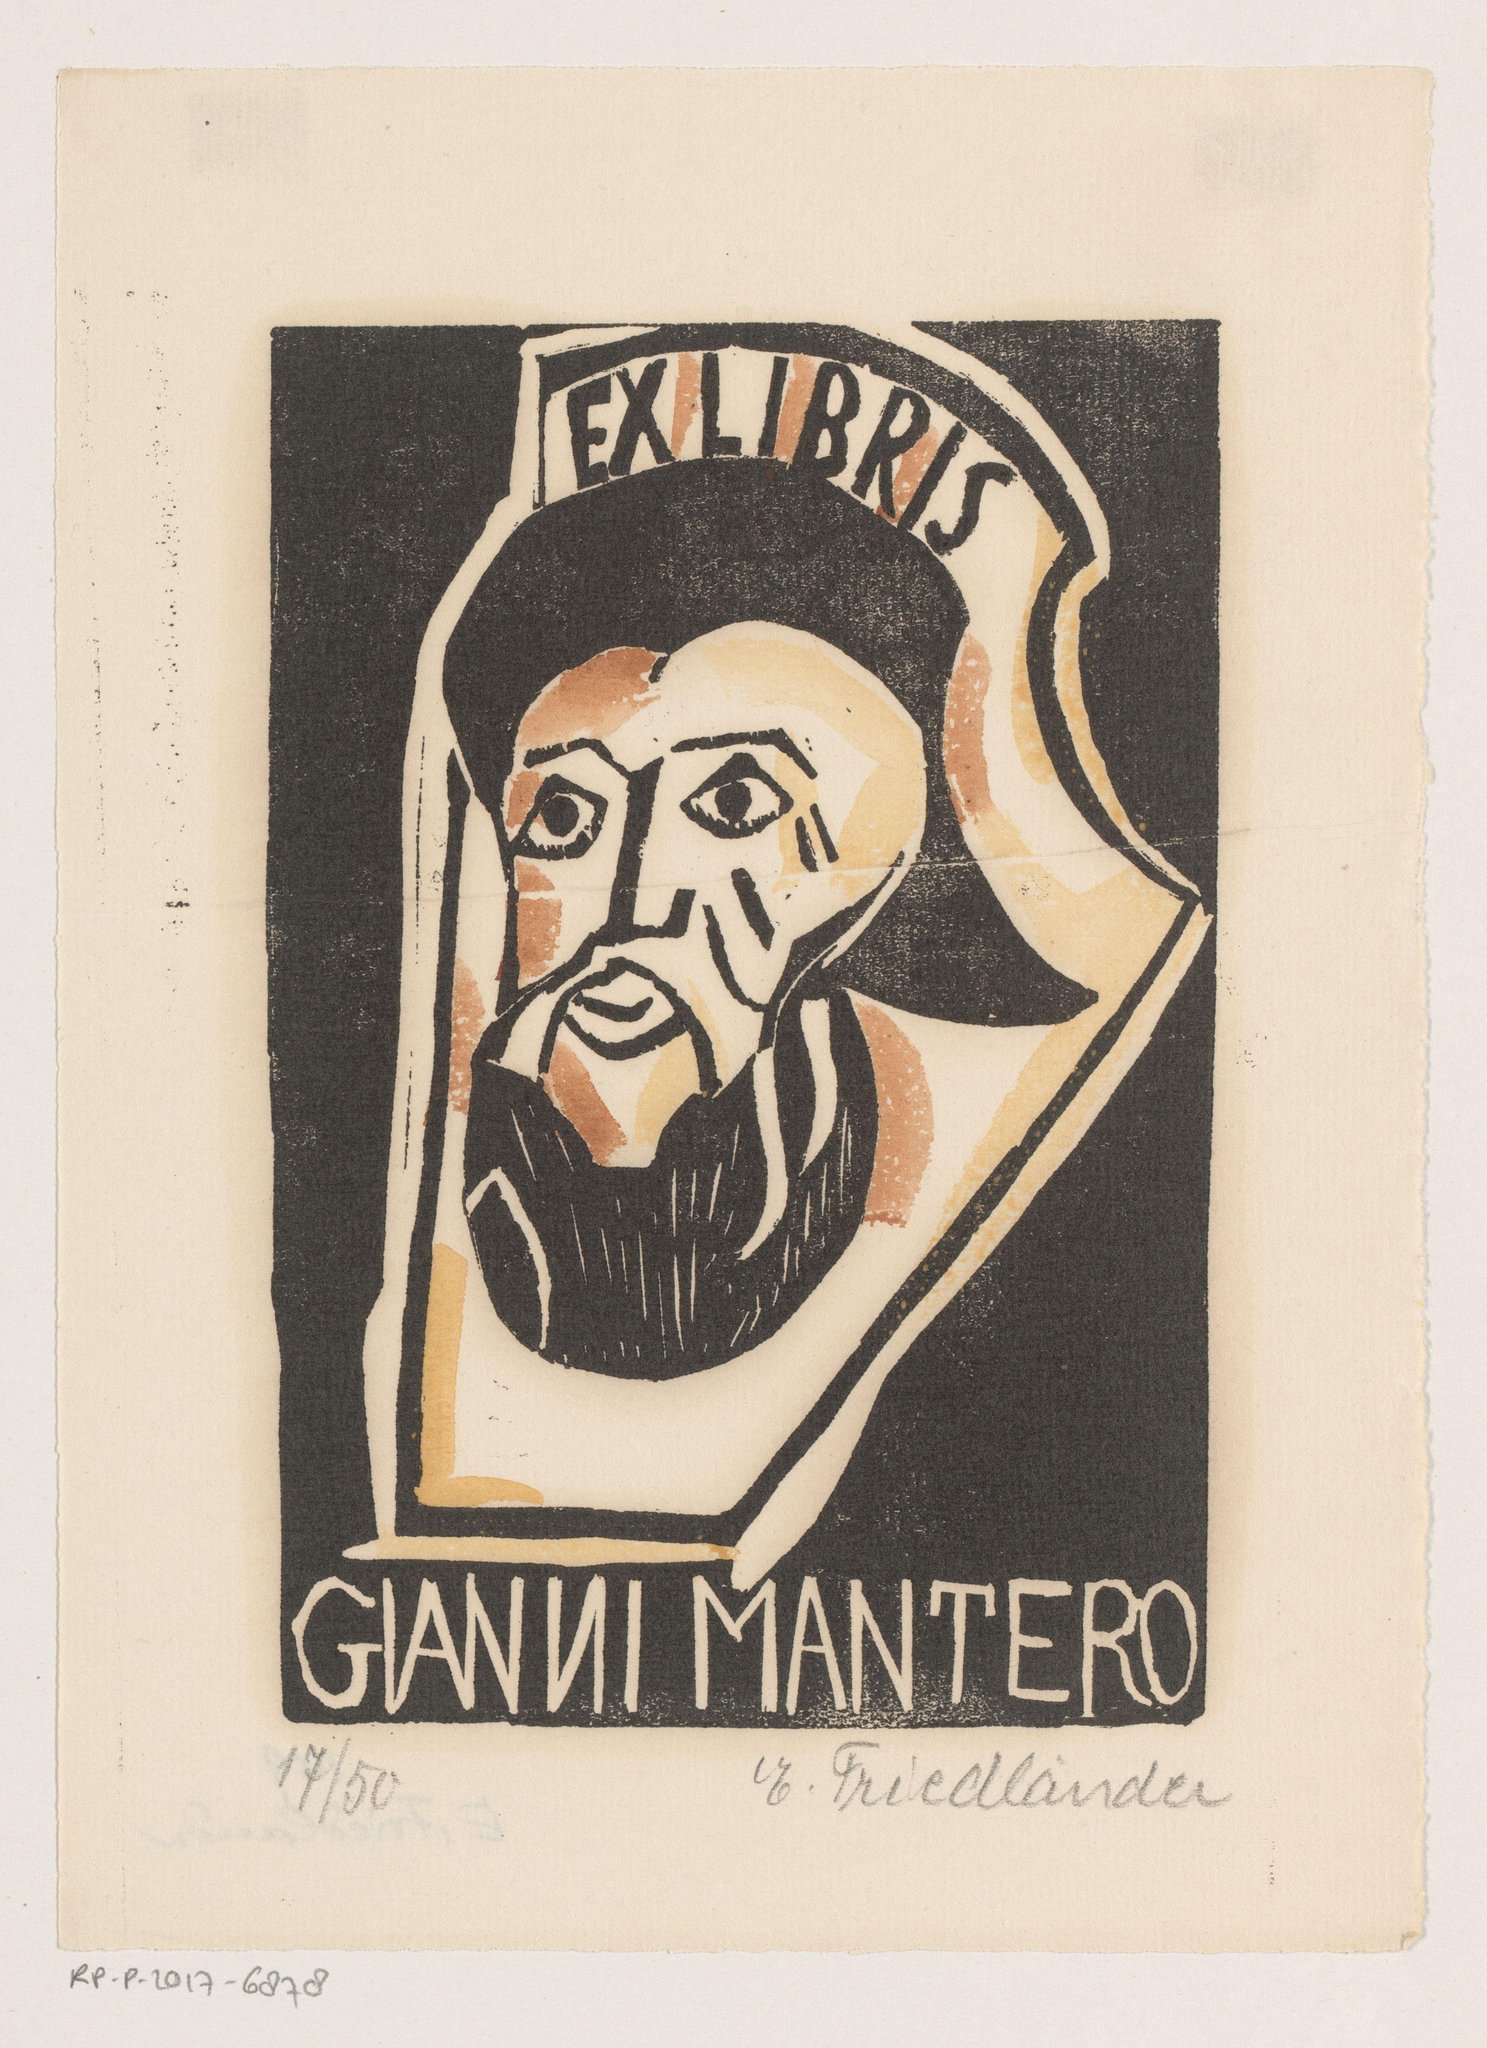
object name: bookplate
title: Ex libris van Gianni Mantero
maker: erna levy friedländer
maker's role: print maker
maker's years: 1890-1979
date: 1907-1985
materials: paper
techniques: hand coloring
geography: germany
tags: engineer, gianni mantero, face, beard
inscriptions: signature: ‘17/50 E. Friedländer’